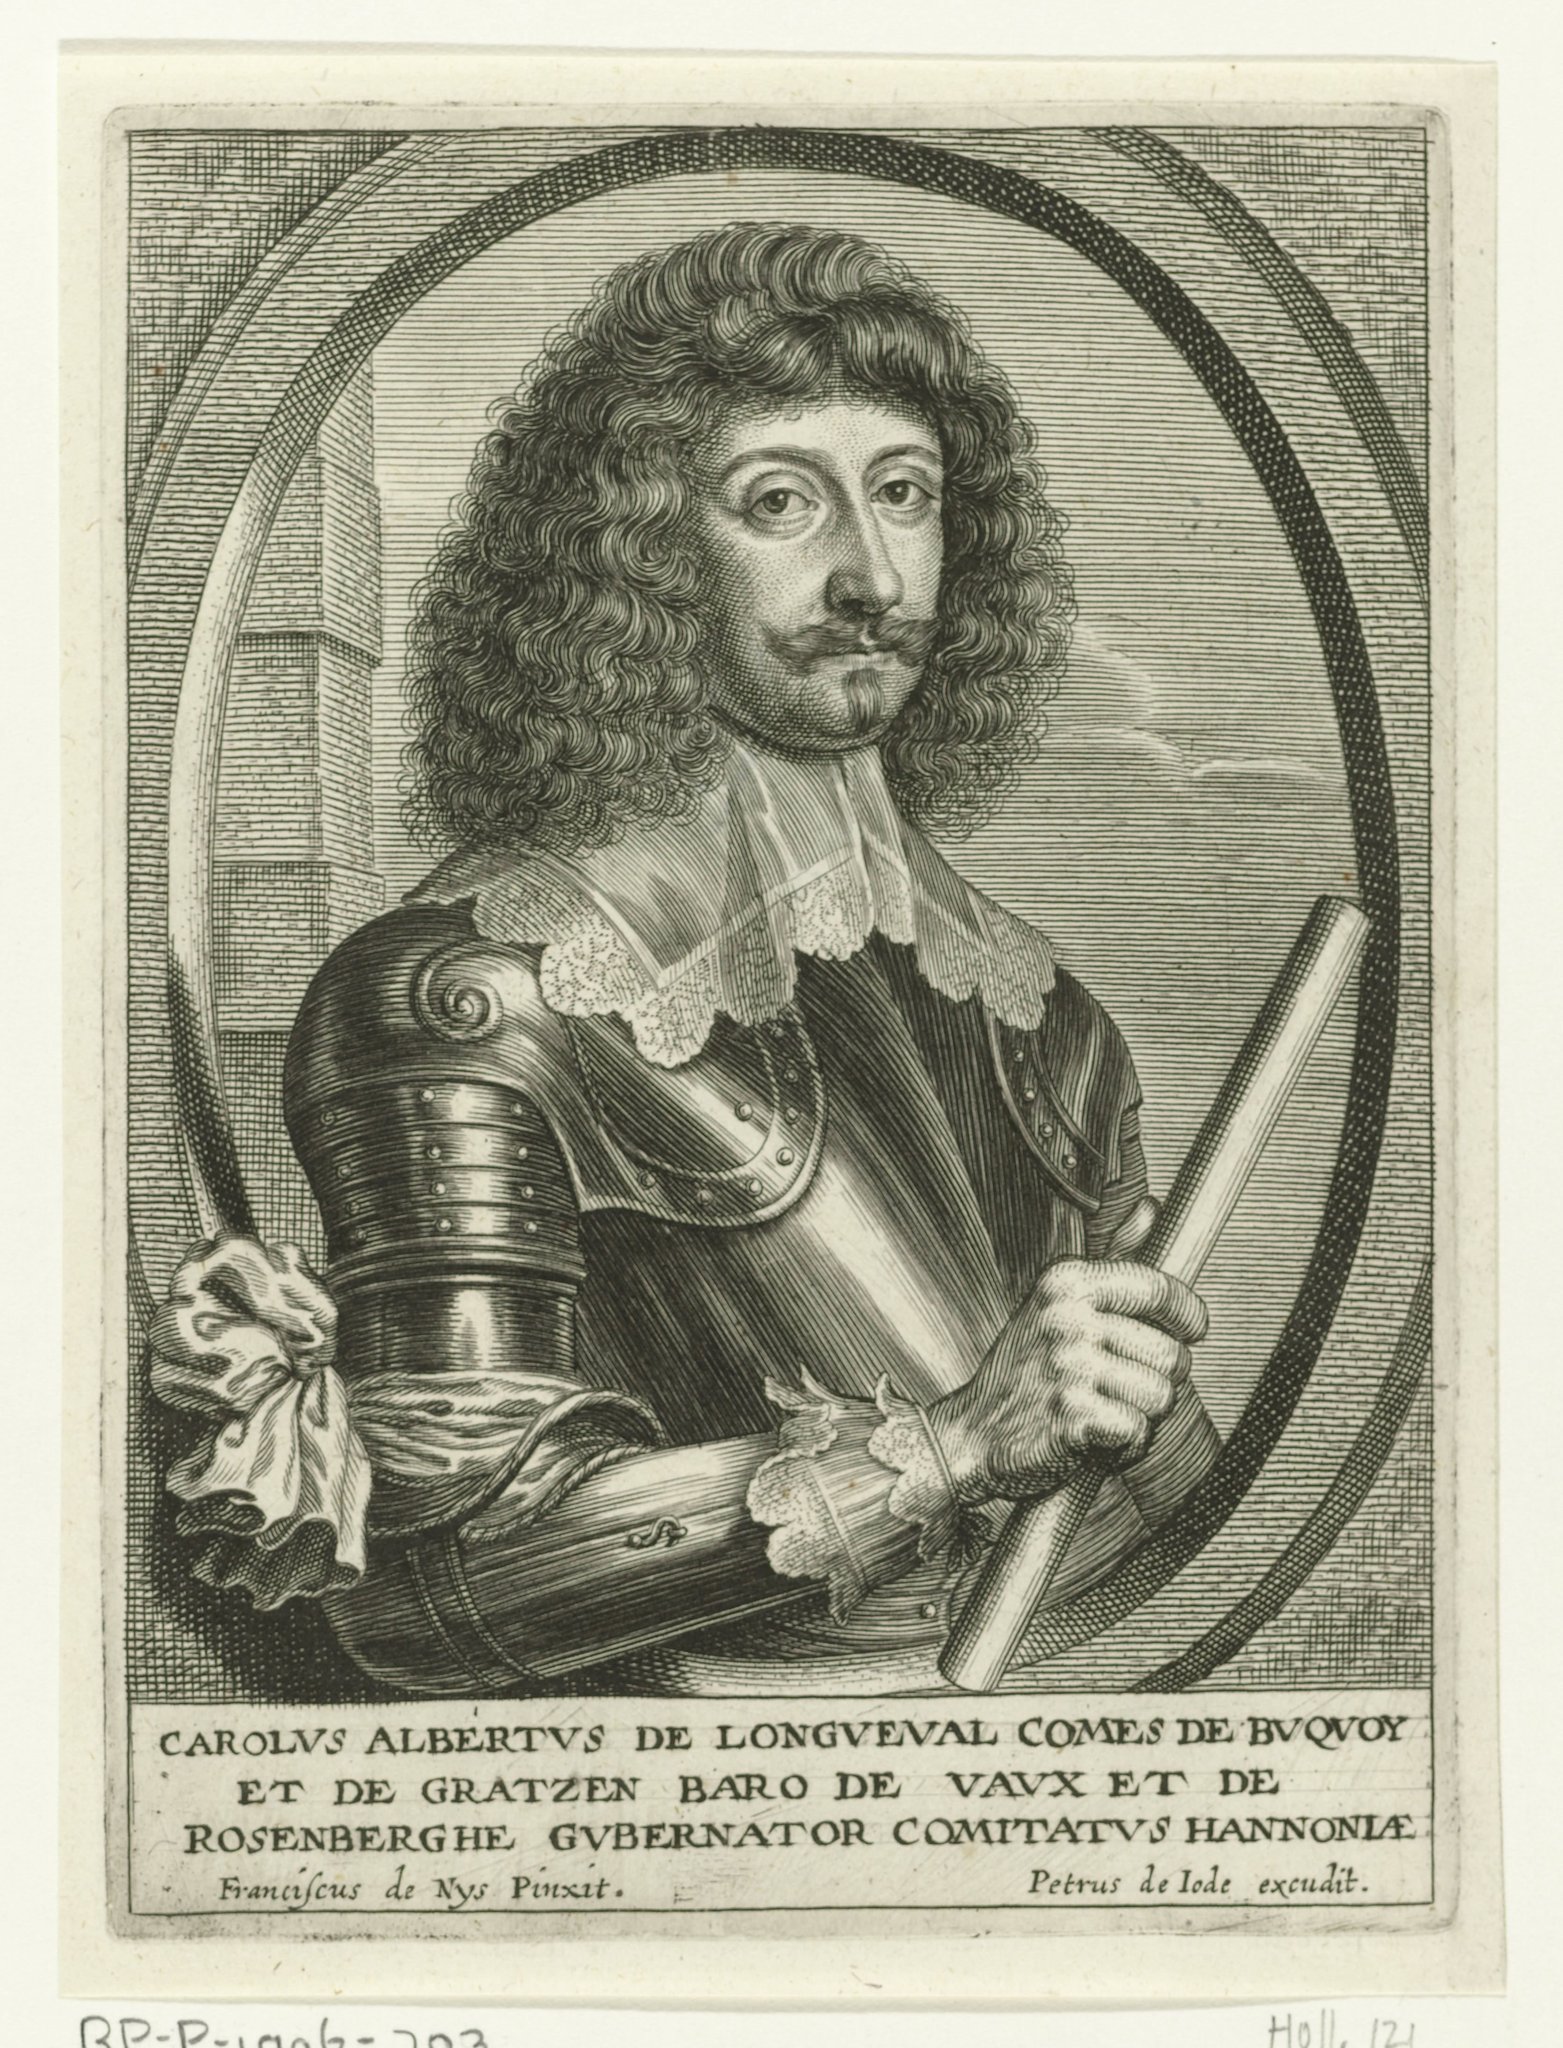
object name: print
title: Busteportret van Karel Albert de Longueval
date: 1628-1670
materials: paper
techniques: engraving, etching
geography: antwerp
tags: bevelhebber, karel albert de longueval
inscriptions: collector's mark: Lugt 2228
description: Busteportret van Karel Albert de Longueval, graaf van Bucquoy, in harnas. In zijn rechterhand houdt hij een commandostaf en met zijn rechterarm leunt hij op de omlijsting. Het portret is gevat in een ovale omlijsting. In de marge een drieregelig onderschrift in het Latijn.